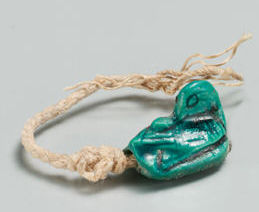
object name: amulet, duck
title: Duck Design-amulet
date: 1479-1458 BCE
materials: linen, stone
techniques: glazing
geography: egypt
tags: ducks